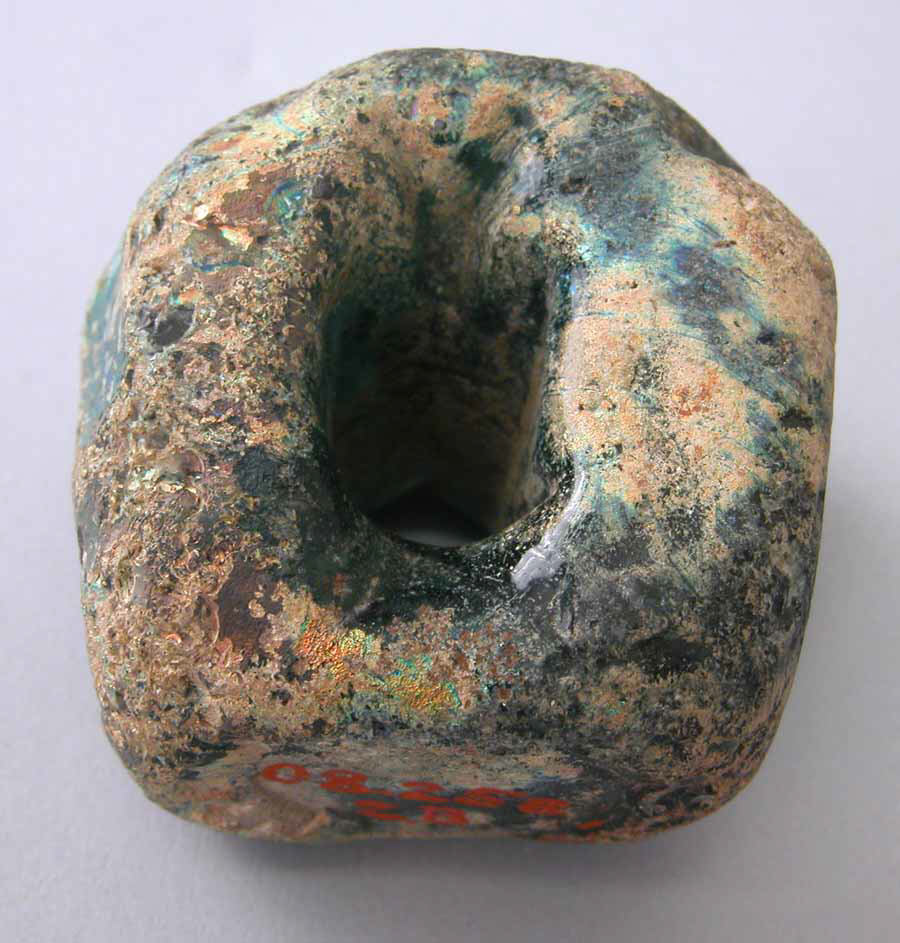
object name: ring weight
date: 601-900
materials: glass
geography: egypt